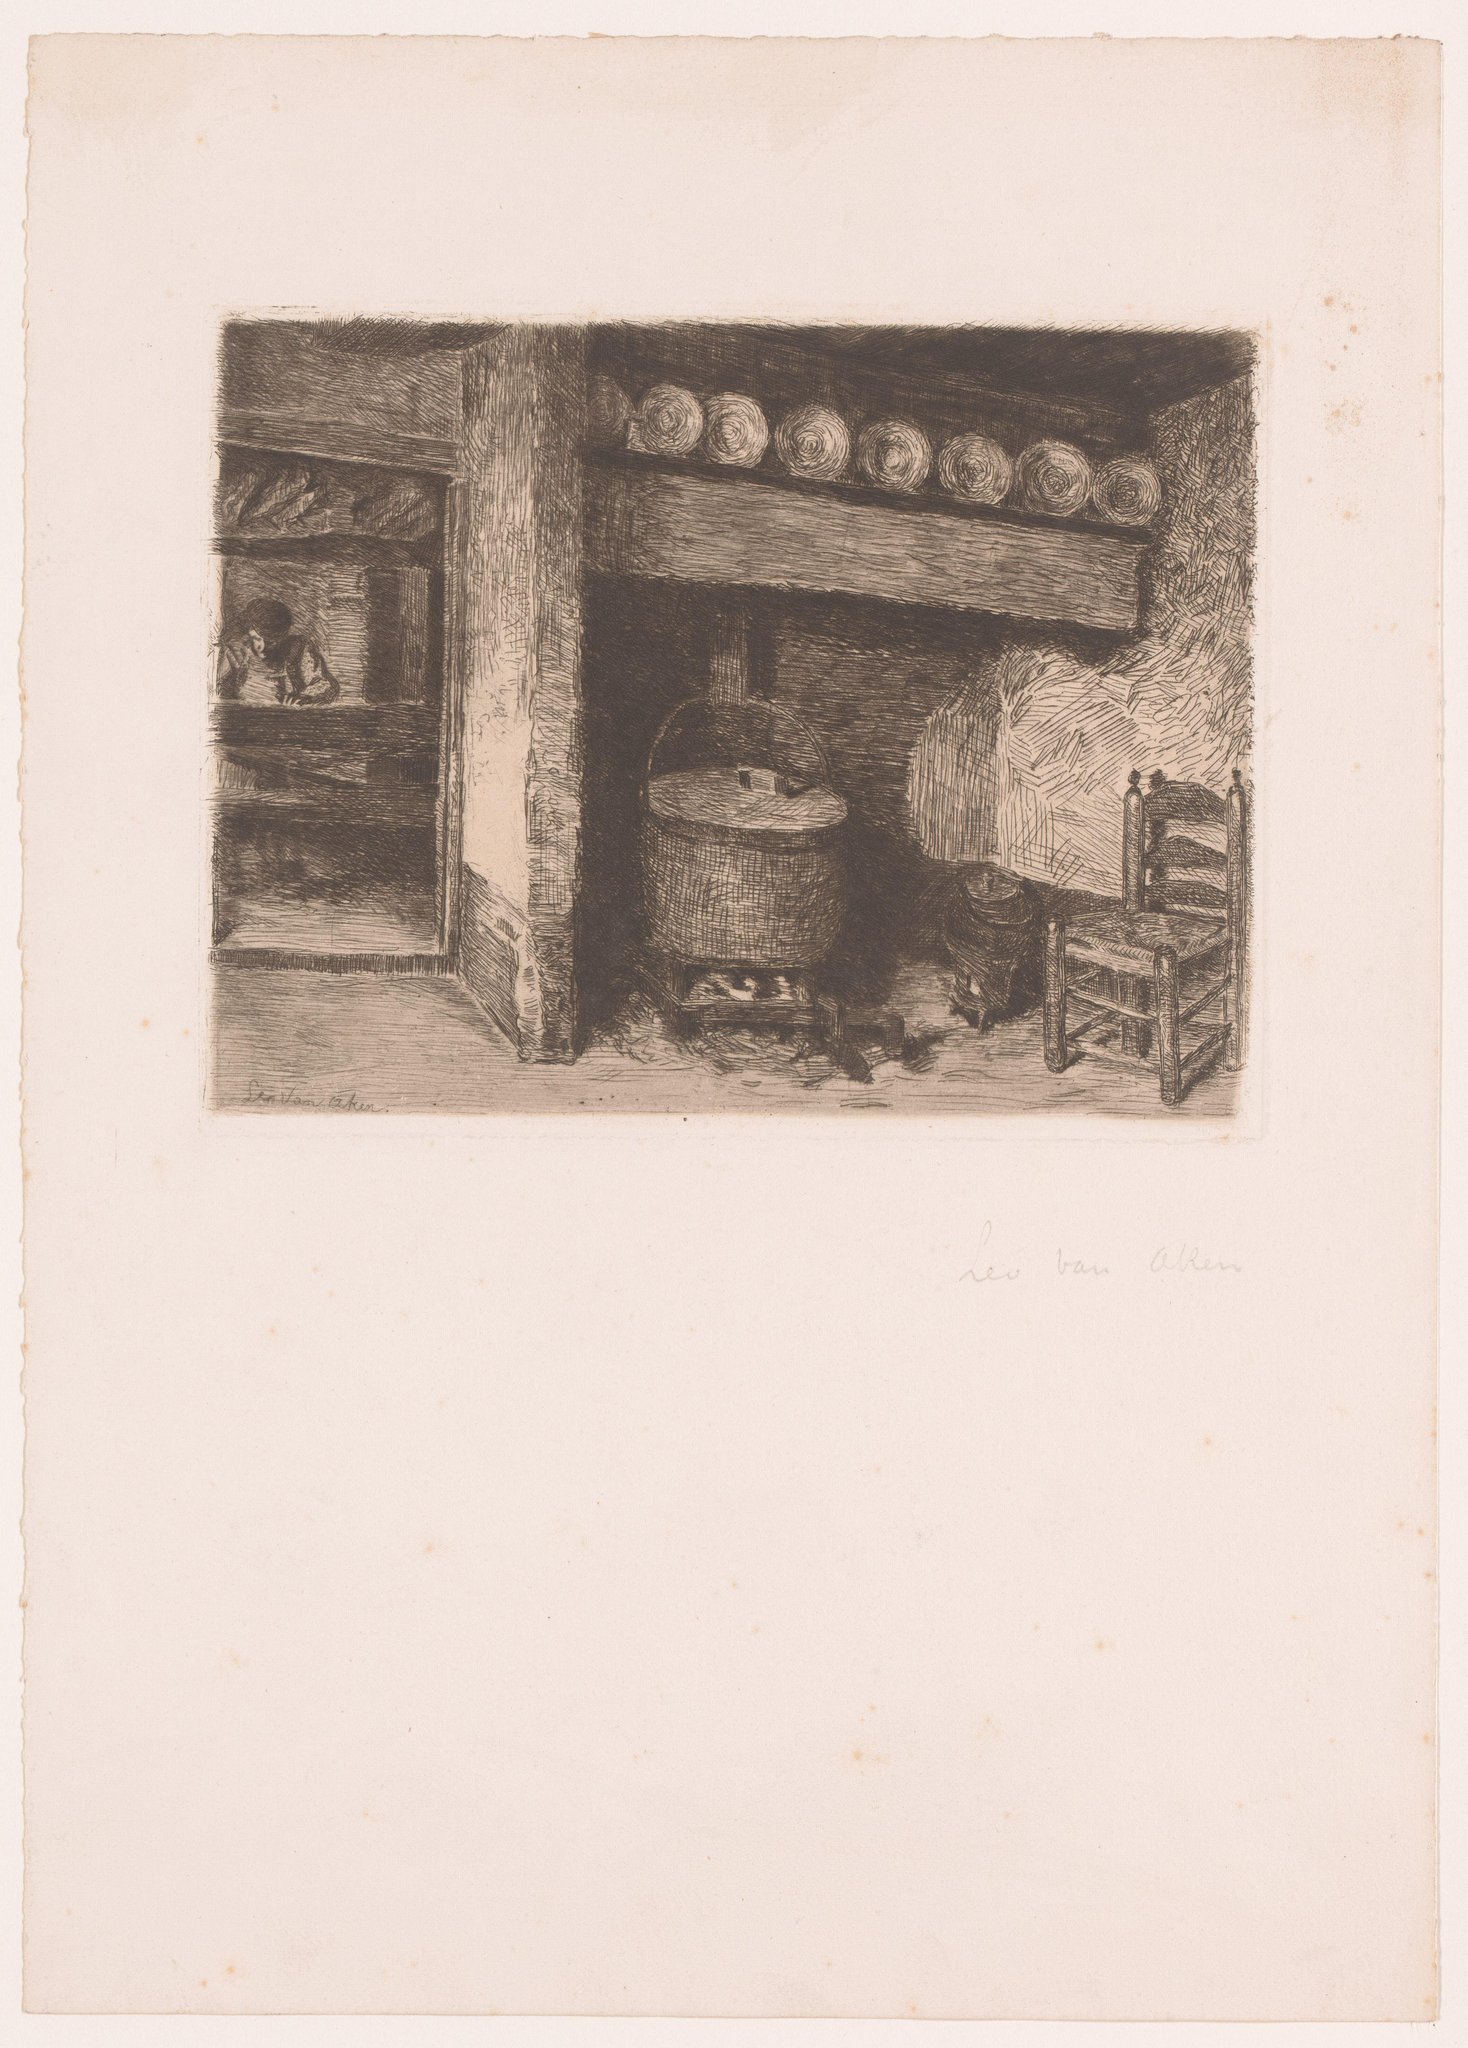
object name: print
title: Keukeninterieur met links een man zittend aan een weefgetouw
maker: leo van aken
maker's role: print maker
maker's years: 1857-1904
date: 1867-1904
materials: paper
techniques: etching, intaglio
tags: kitchen-interior, weaving-loom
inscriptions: check stamp: ‘Les XIII’, collector's mark: Lugt 2228